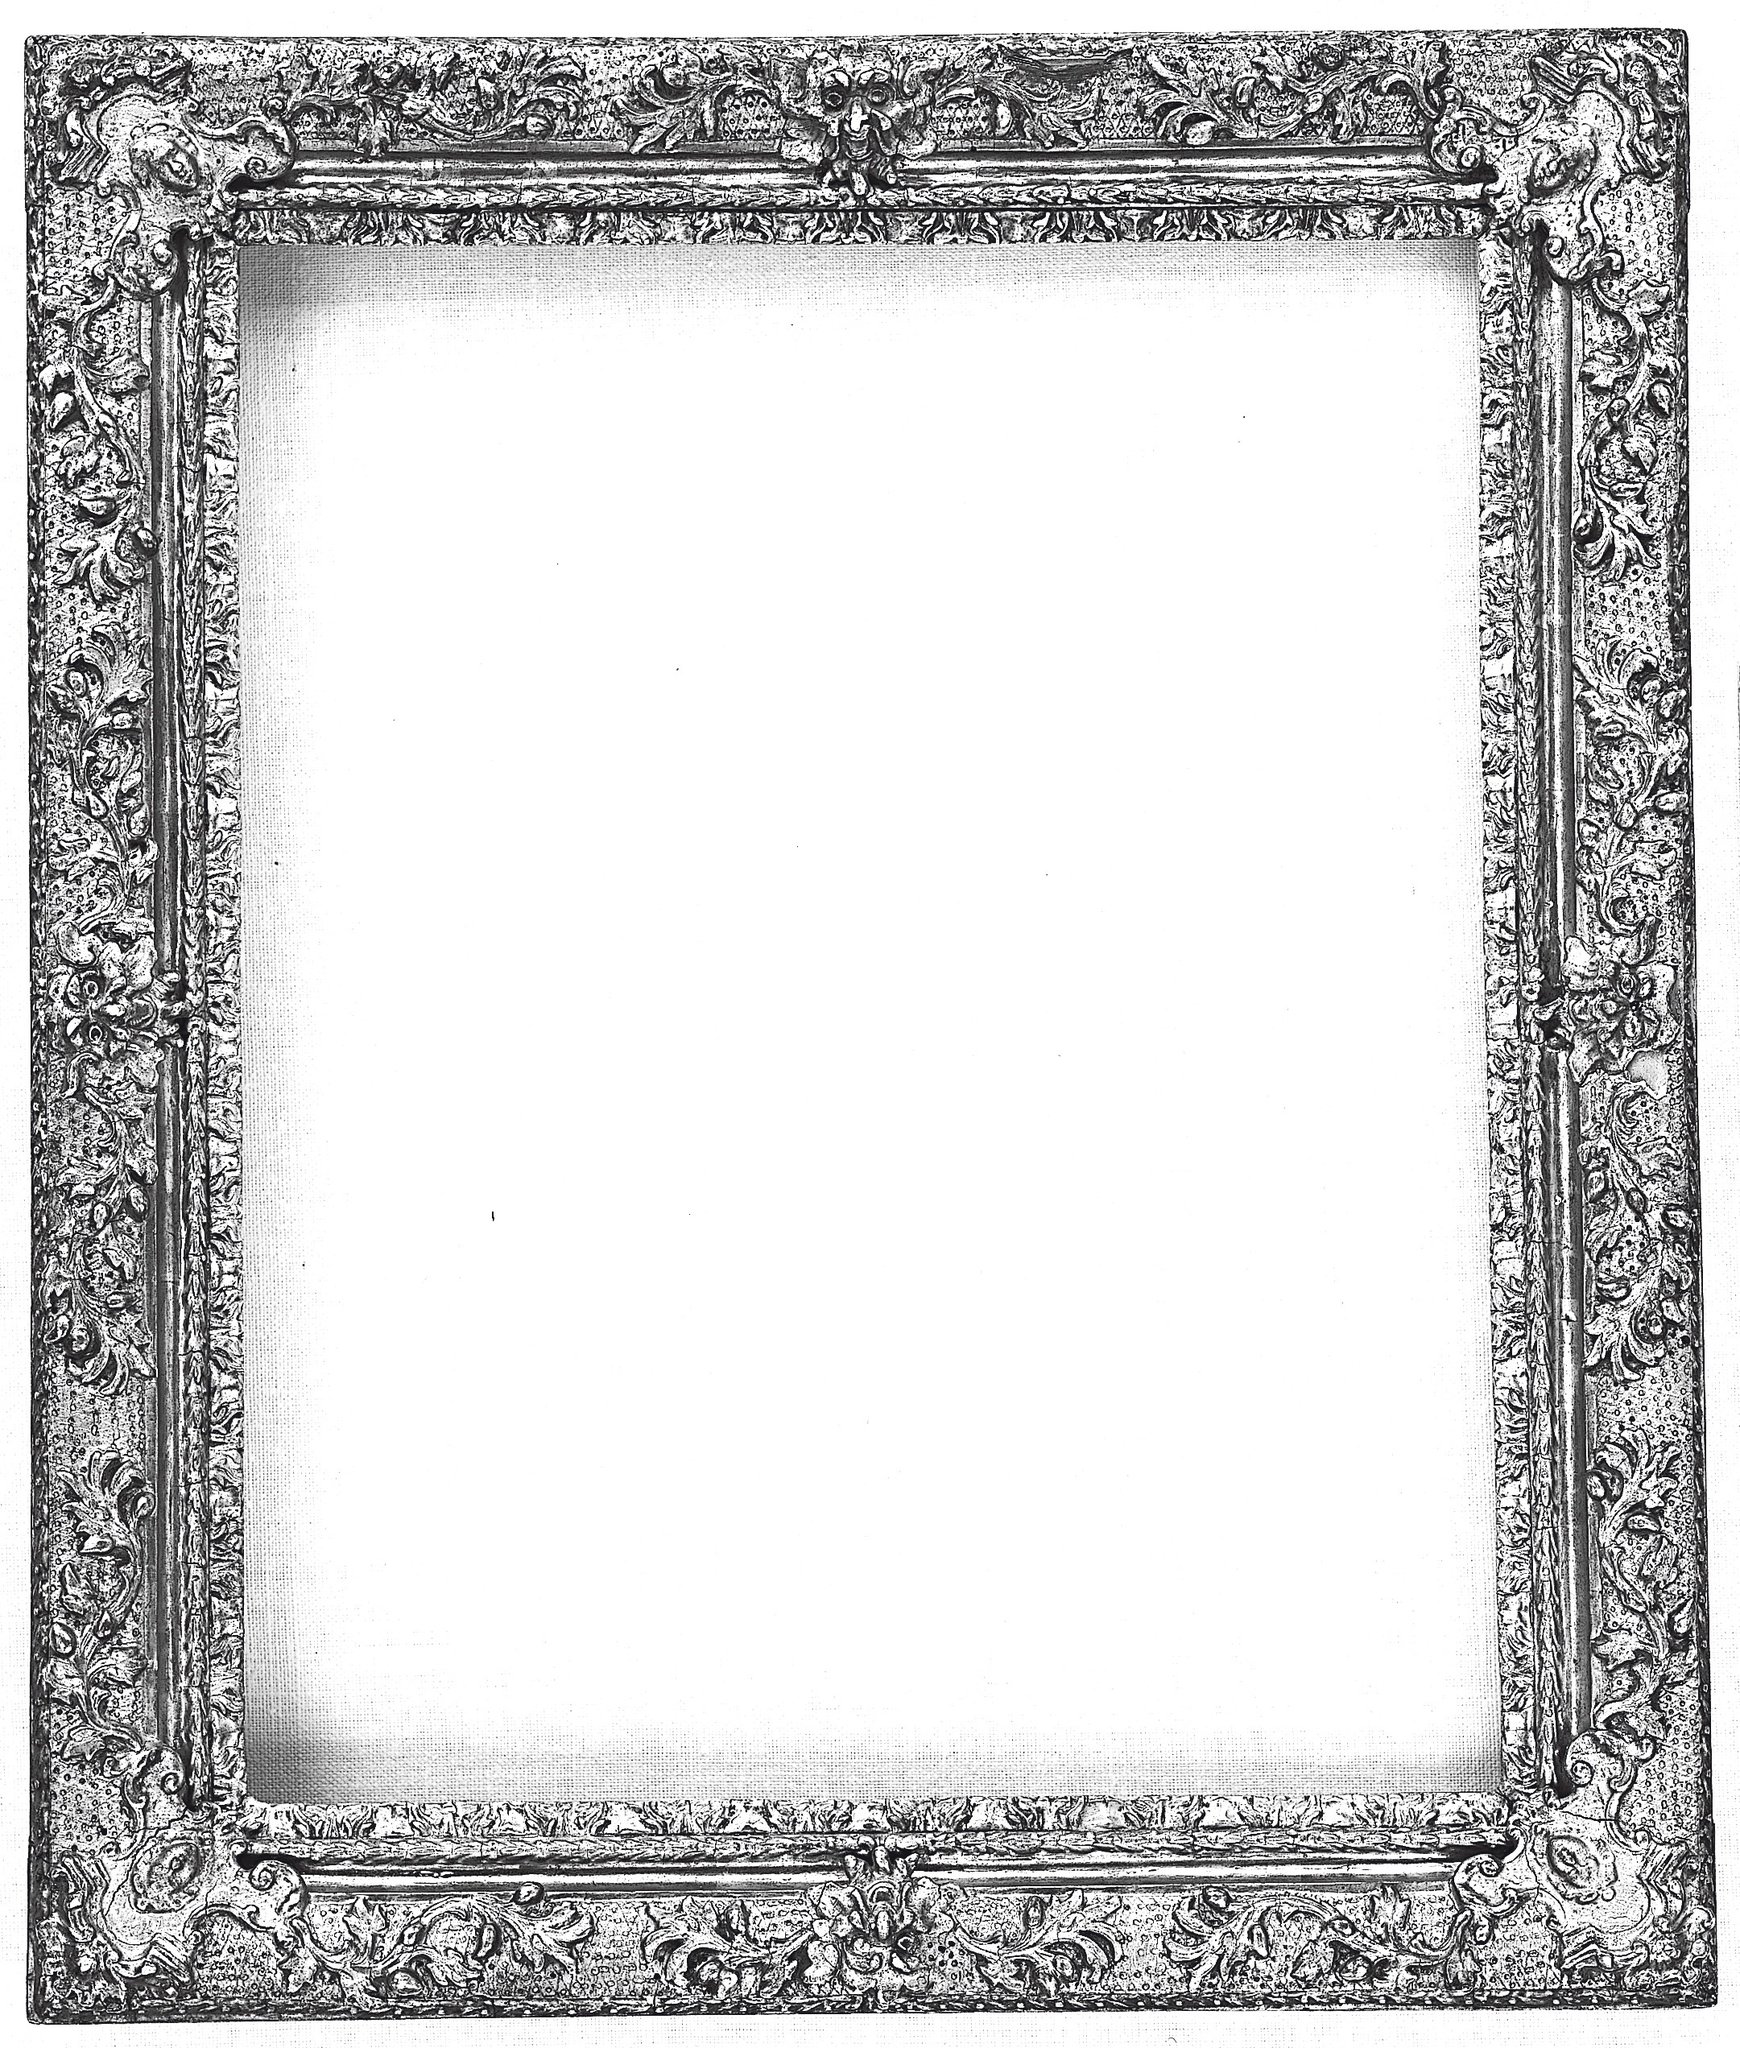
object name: frame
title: Louis XIV-style frame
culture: italian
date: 1772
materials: wood